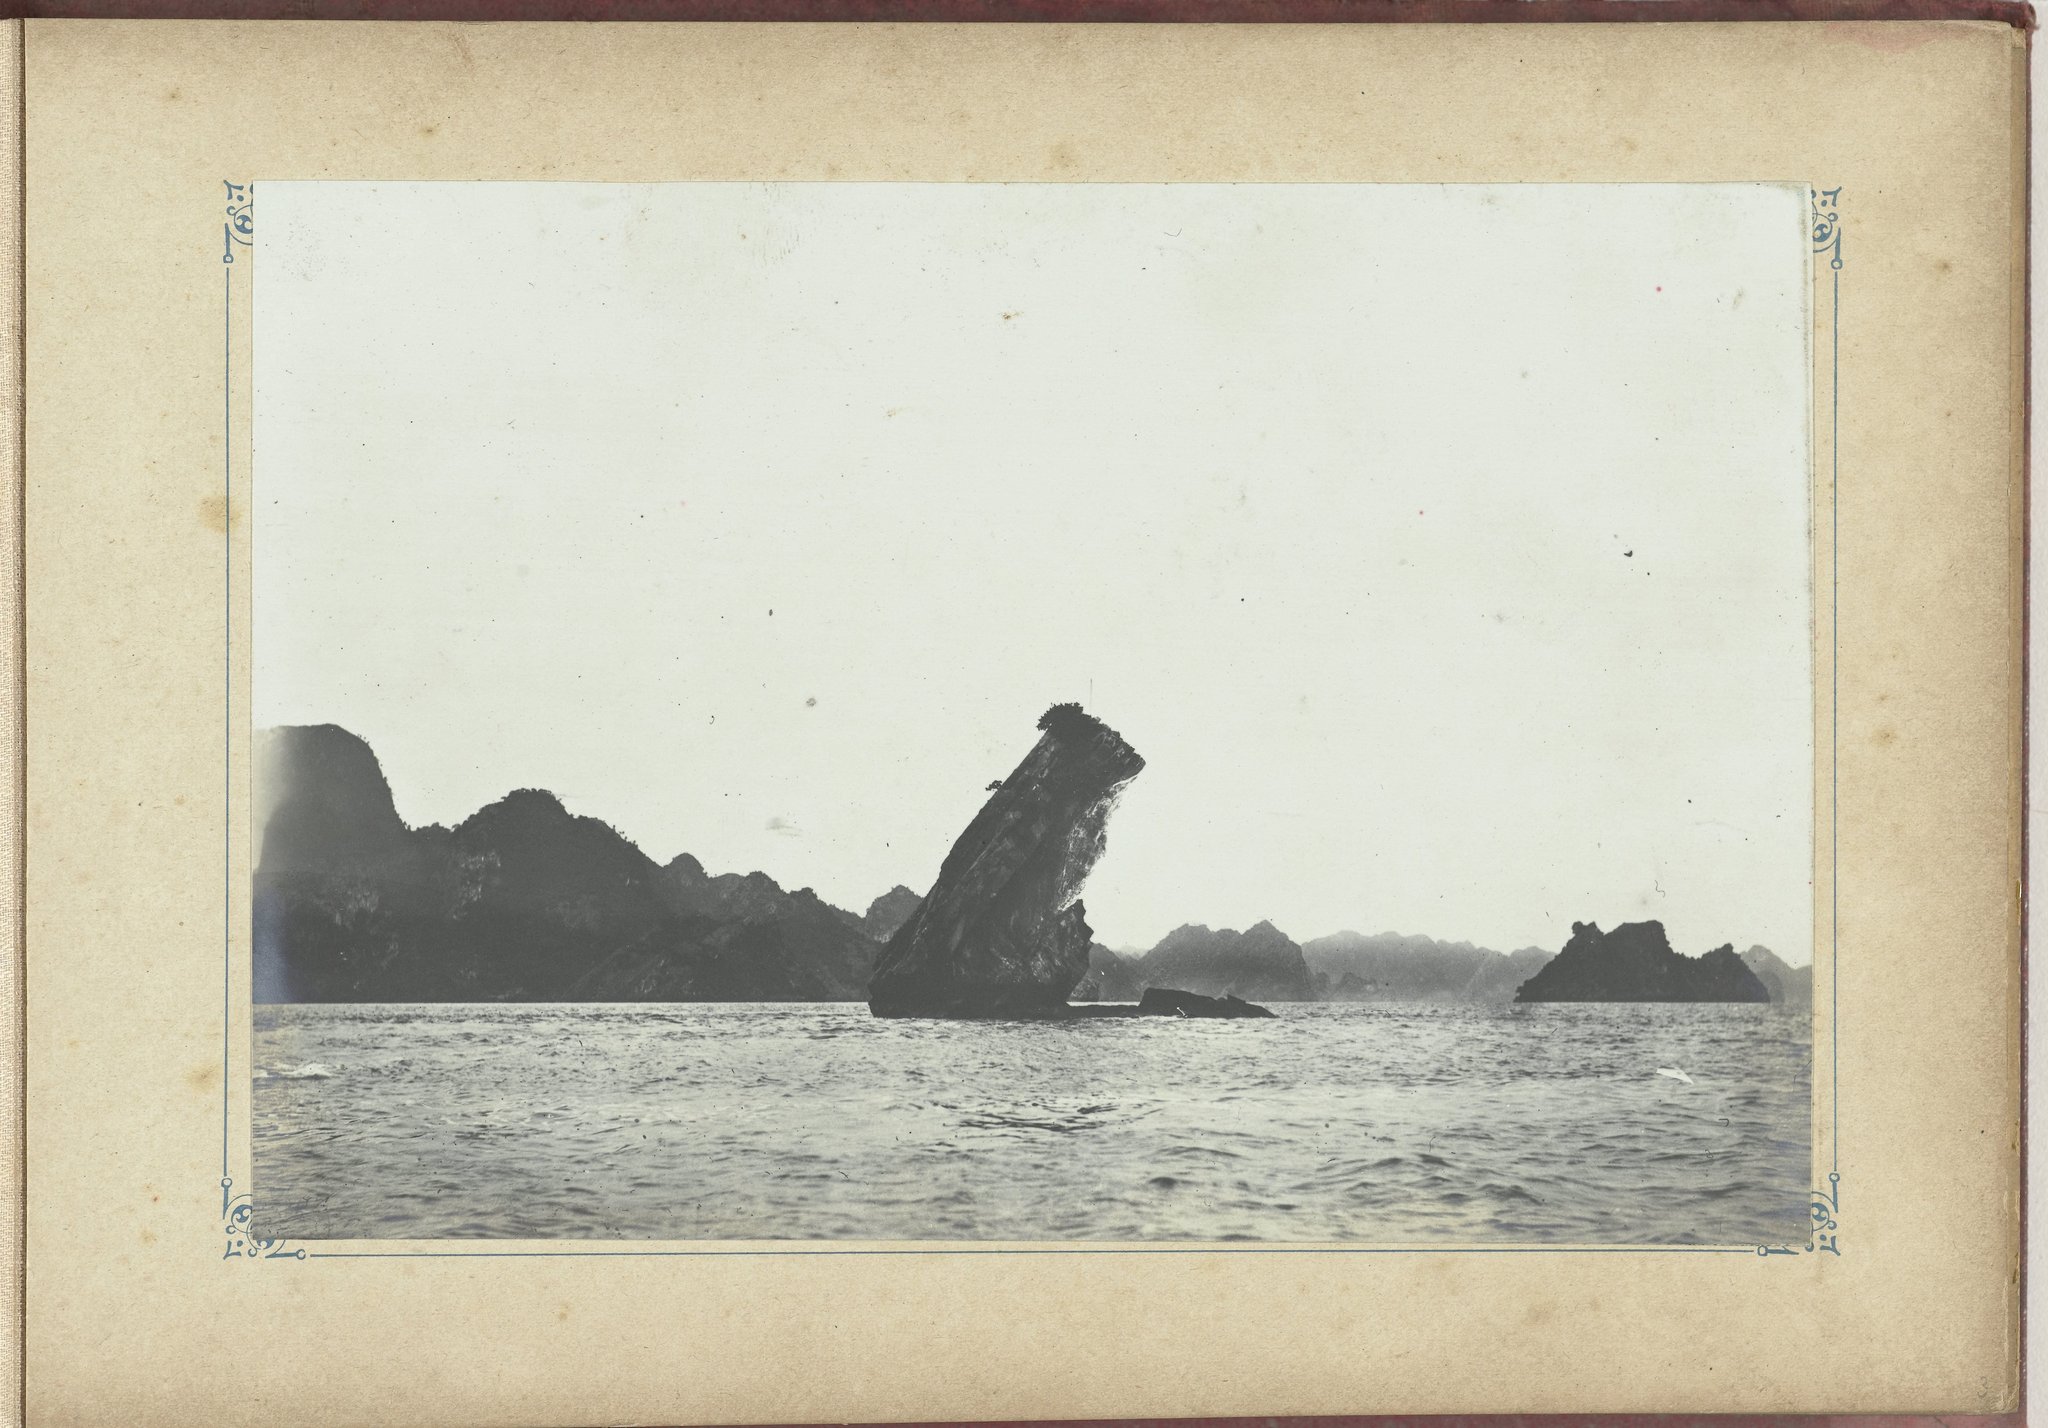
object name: photograph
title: Eilanden in de Ha Longbaai, Frans-Indochina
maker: Anonymous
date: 1902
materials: paper, cardboard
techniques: gelatin silver print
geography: vietnam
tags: island, sea (seascape), rock-formations